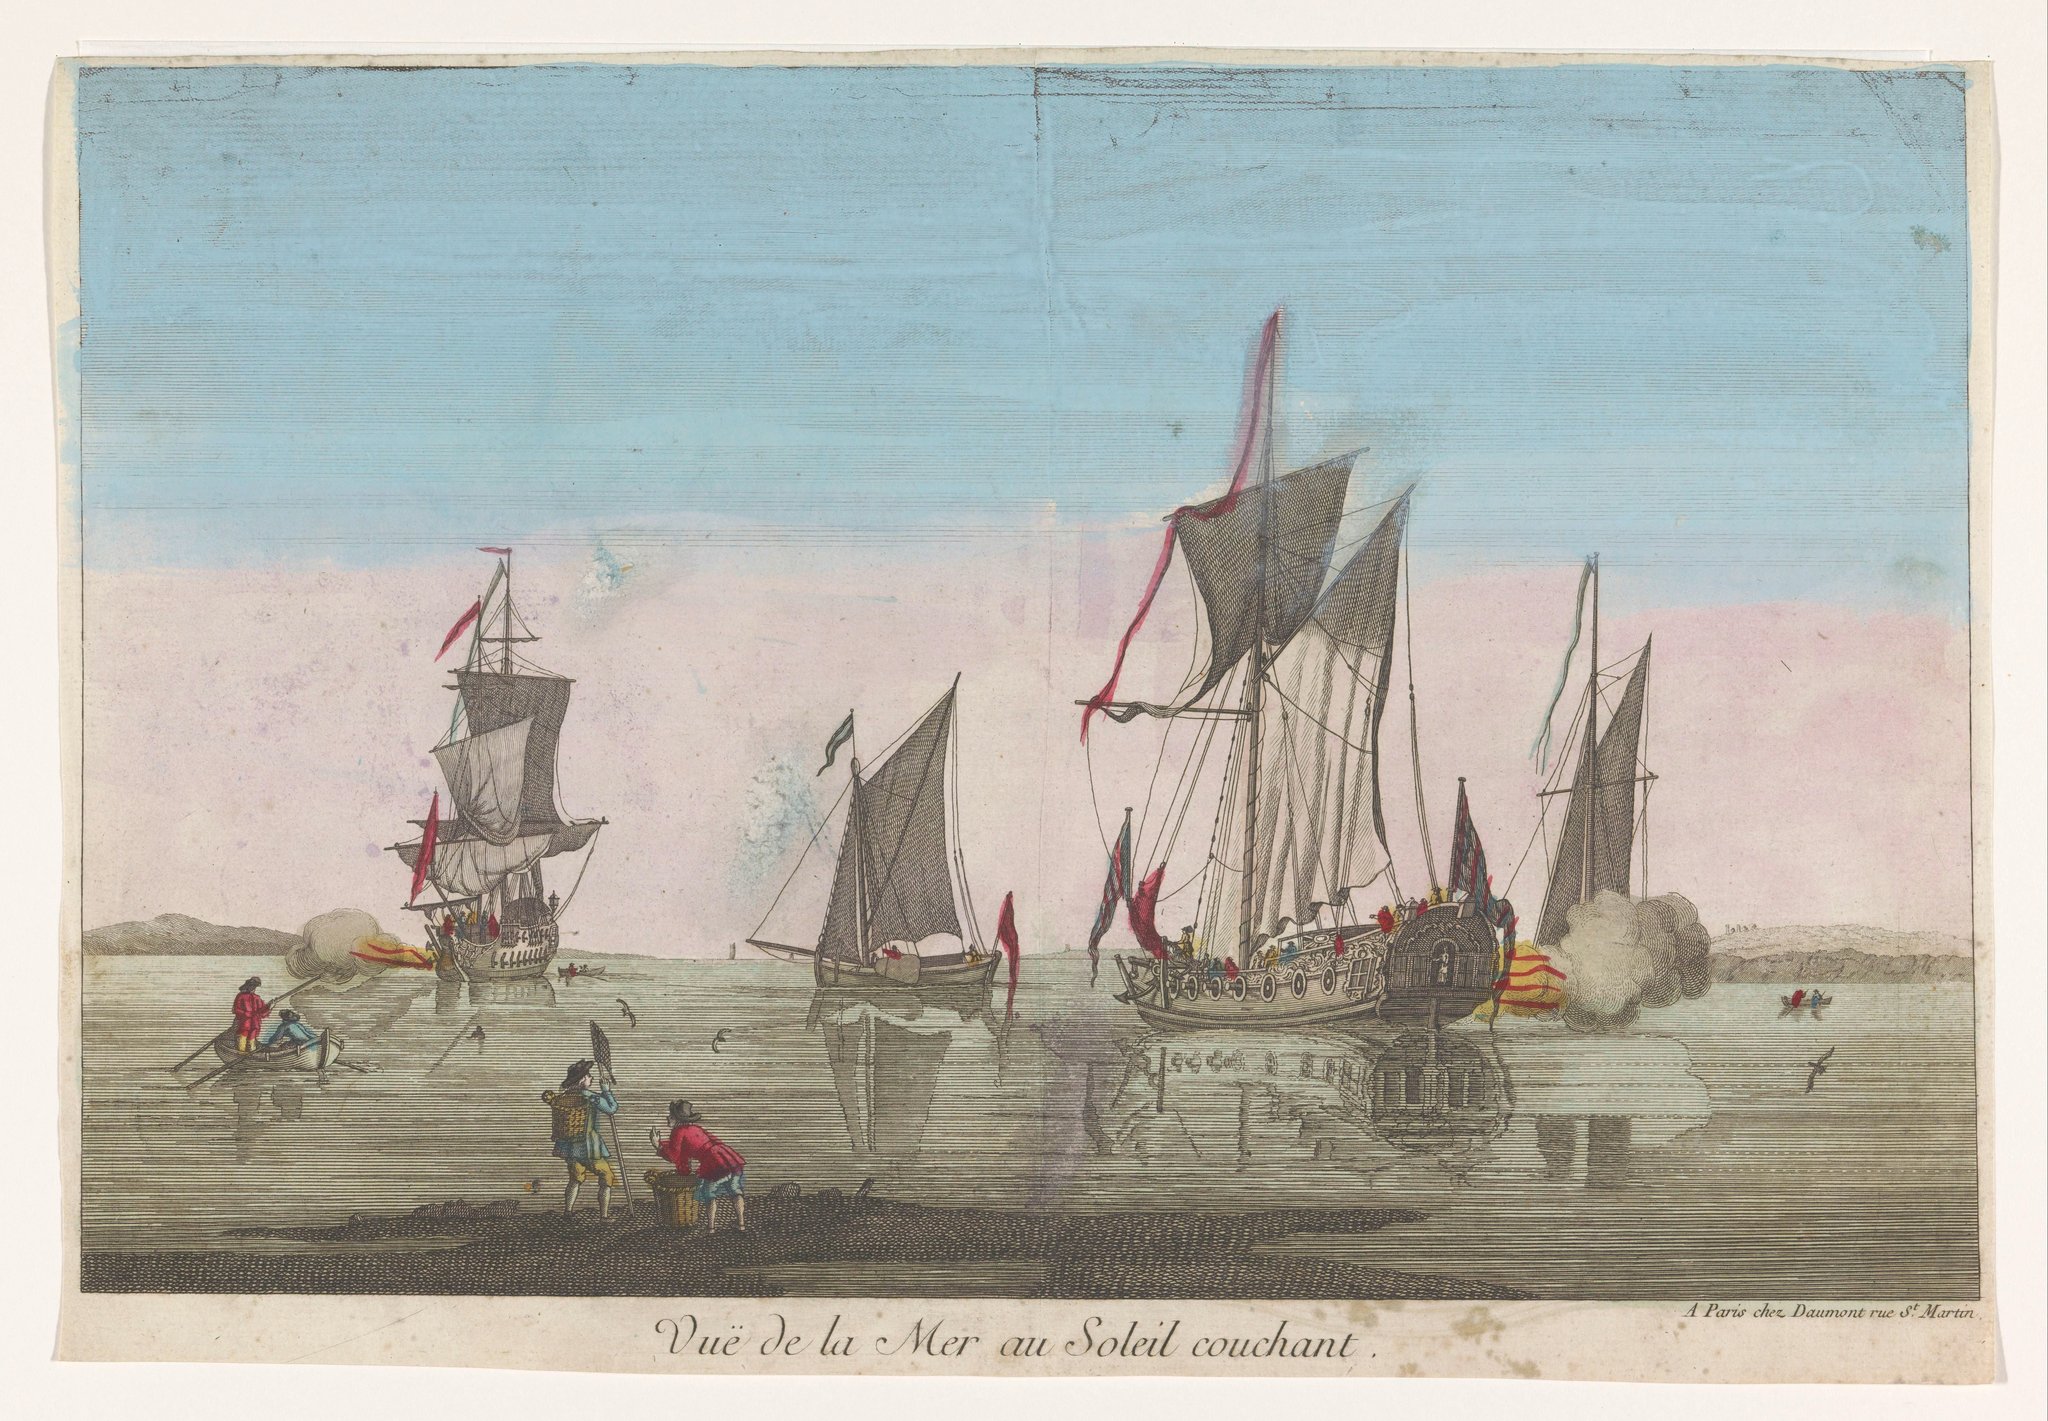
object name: print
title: Vuë de la mer au soleil couchant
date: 1745-1775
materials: paper, watercolor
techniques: brush, etching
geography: france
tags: sailing-ship, sailing-boat, rowing-boat, canoe, etc., sunset, sea (seascape) (+ landscape with figures, staffage)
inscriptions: watermark, collector's mark: Lugt 2233